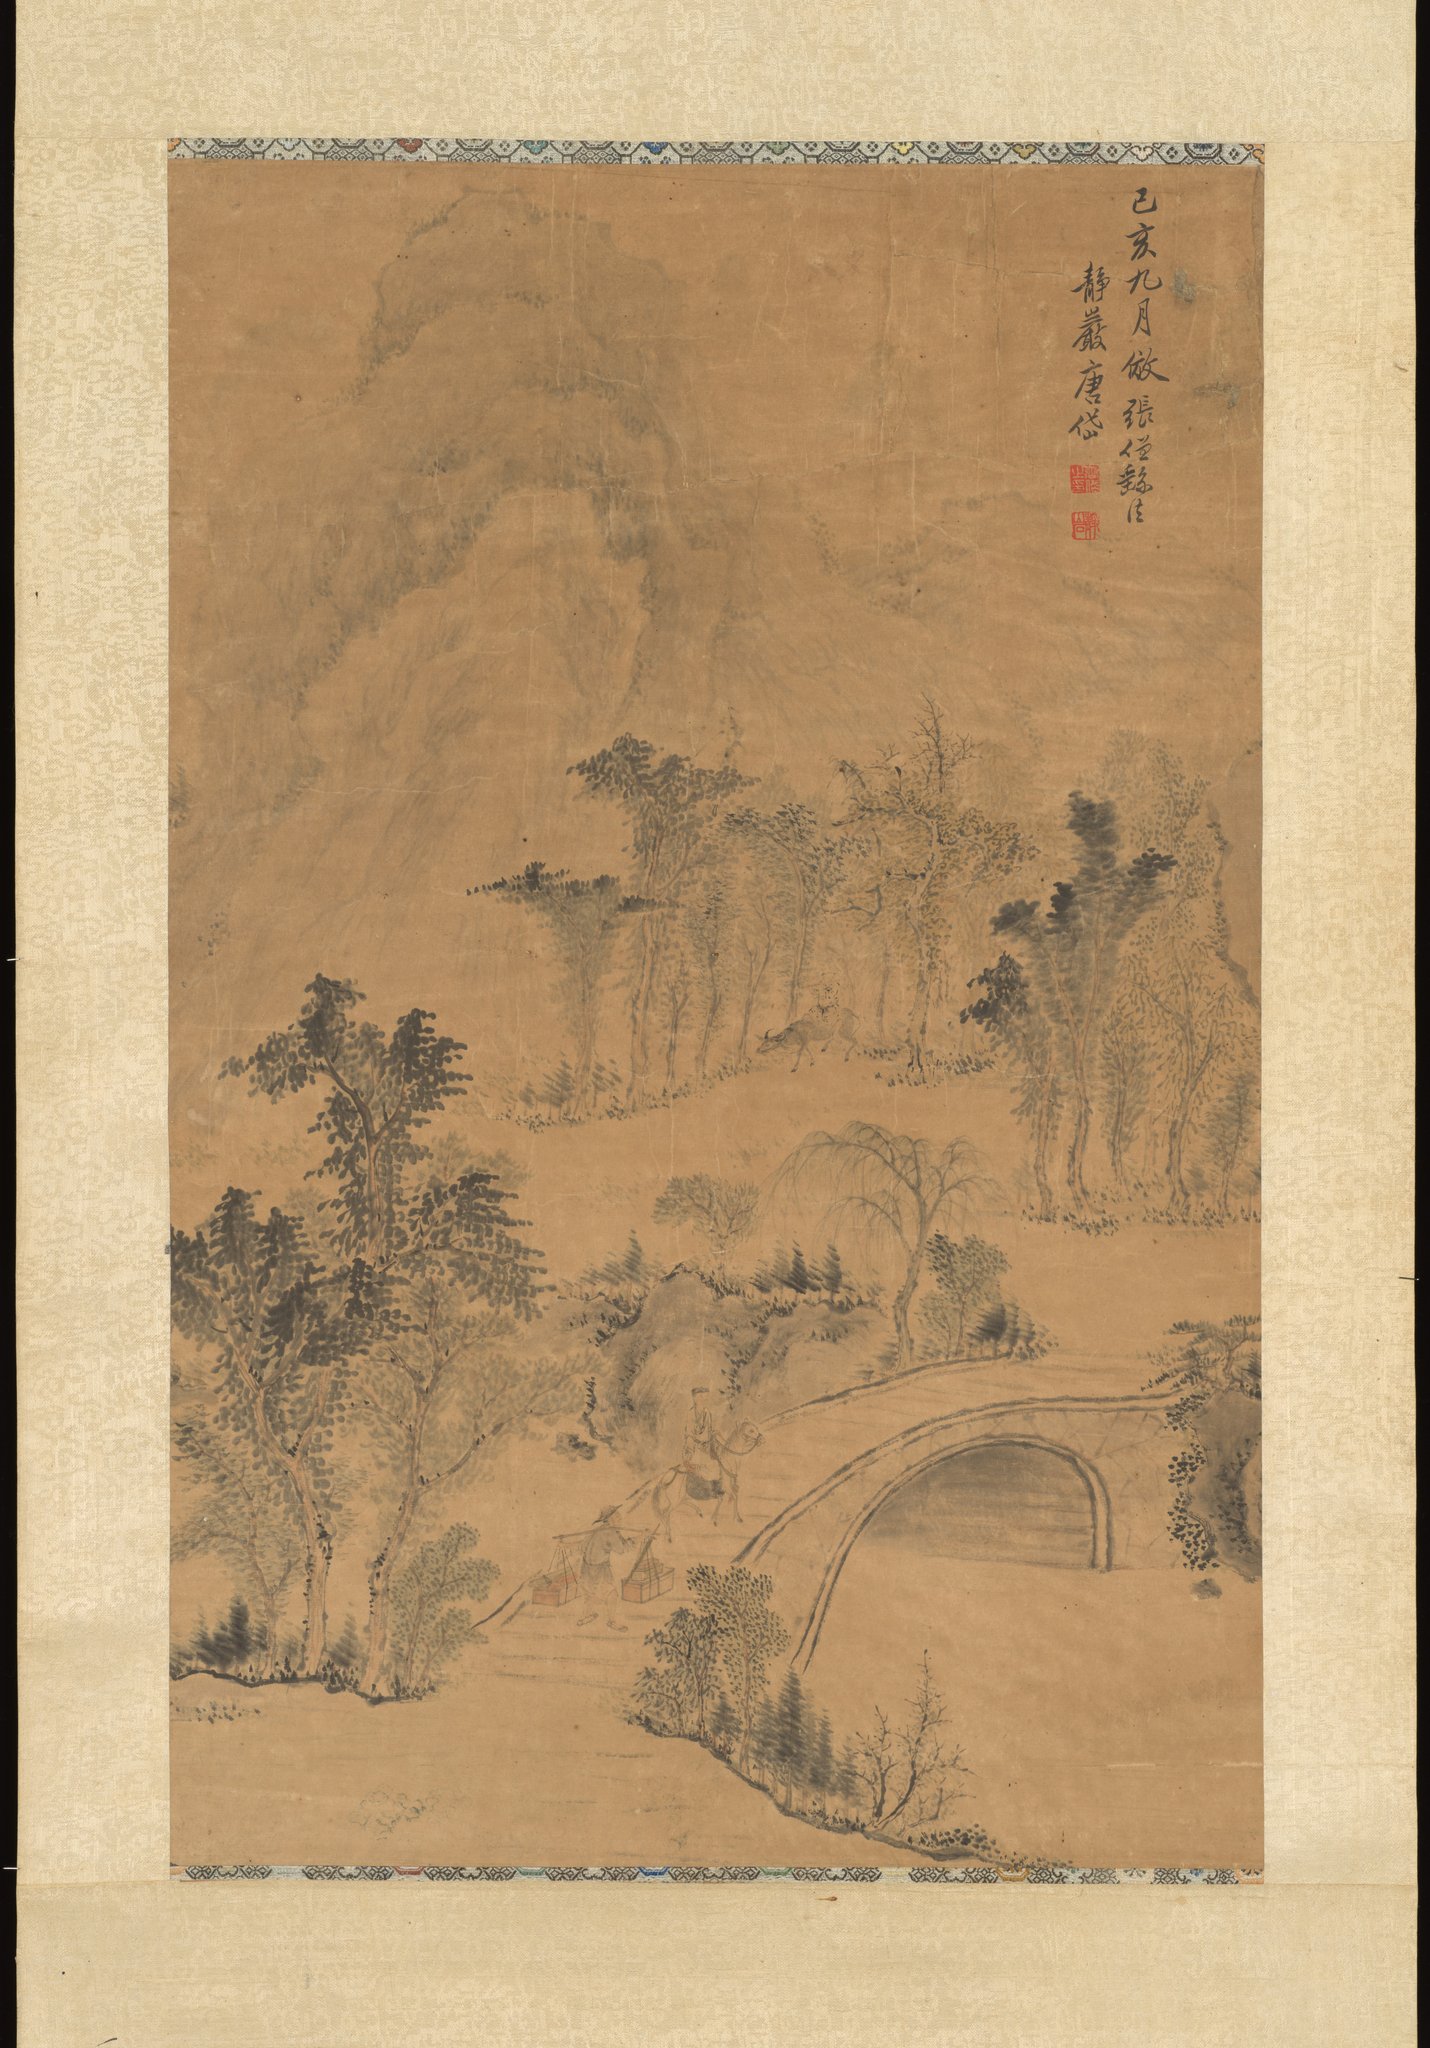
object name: hanging scroll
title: Landscape after Zhang Sengyu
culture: chinese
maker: tang dai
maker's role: artist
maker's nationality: chinese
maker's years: 1736-1795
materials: ink, paper